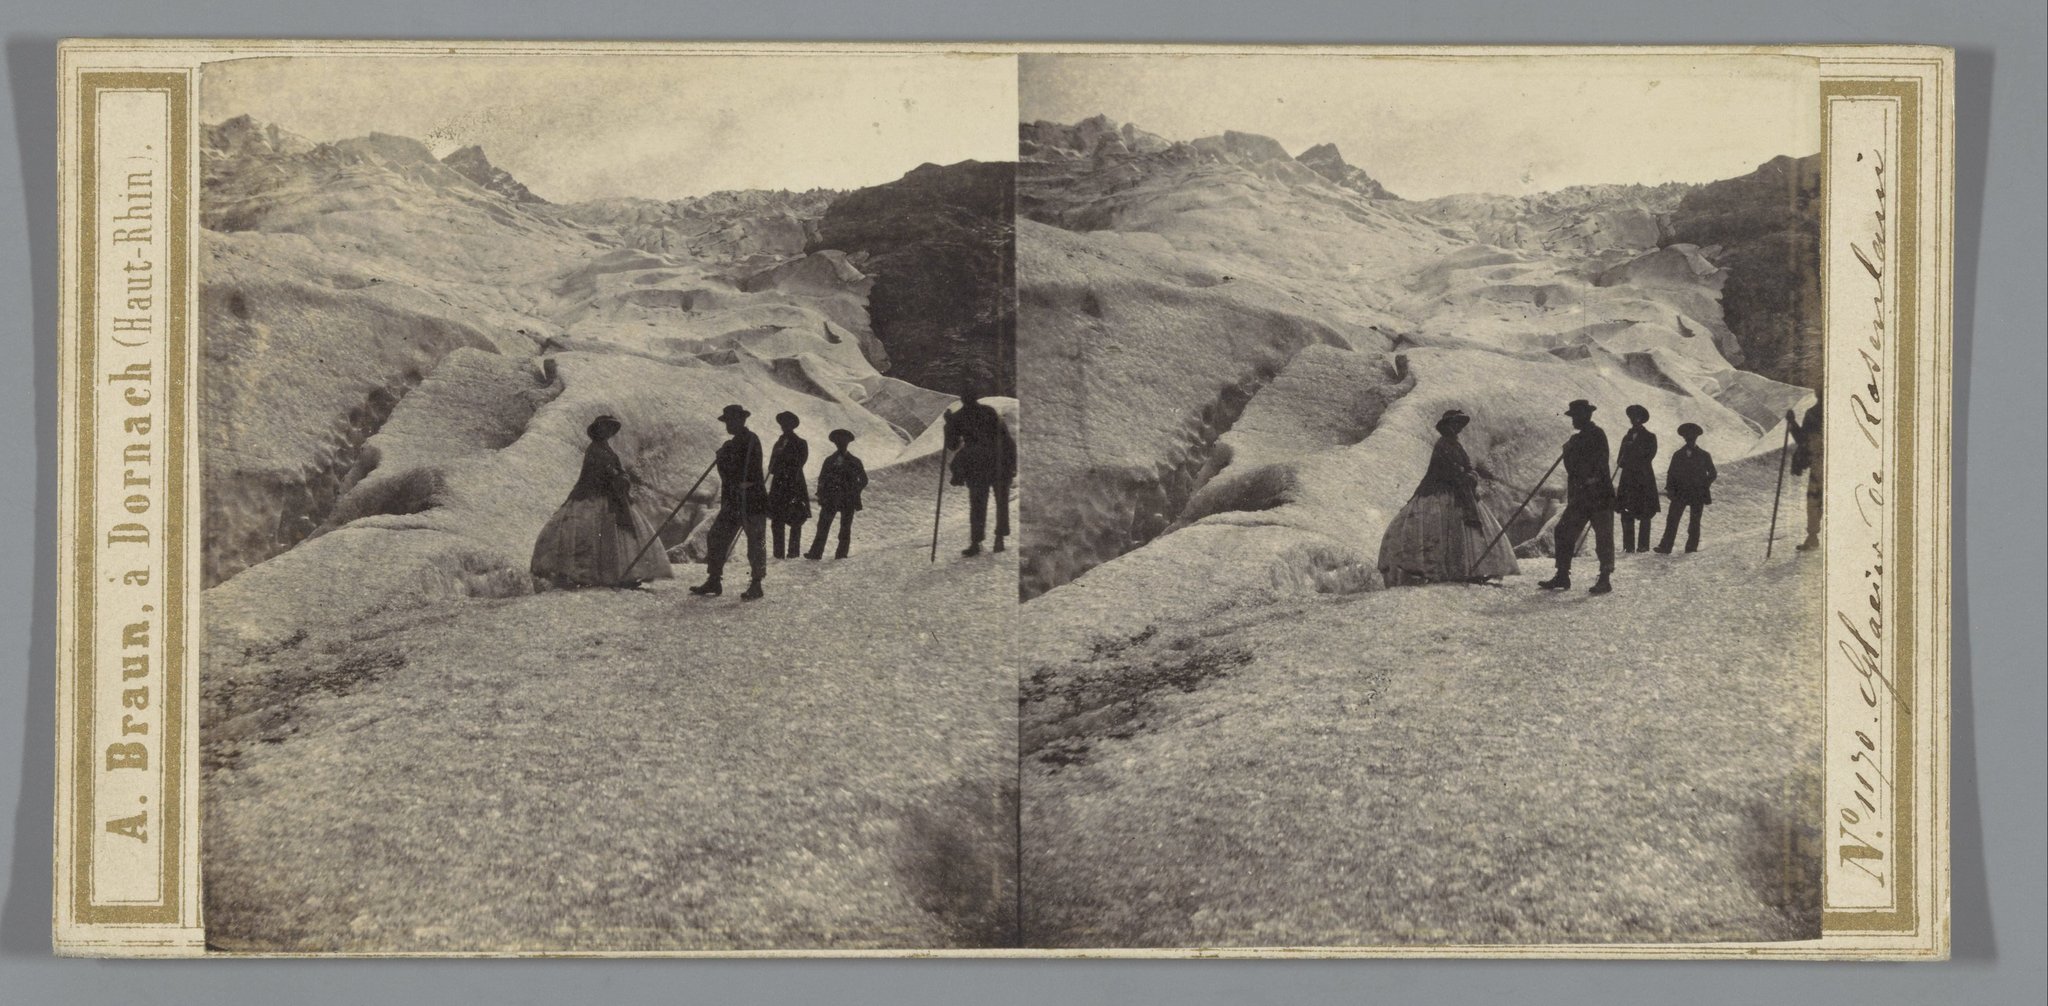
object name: stereograph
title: Glacier de Rosenlaui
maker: Anonymous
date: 1860-1866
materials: cardboard, paper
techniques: albumen print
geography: dornach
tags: mountain climbing, mountaineering, glacier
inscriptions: number: ‘No. 1170.’